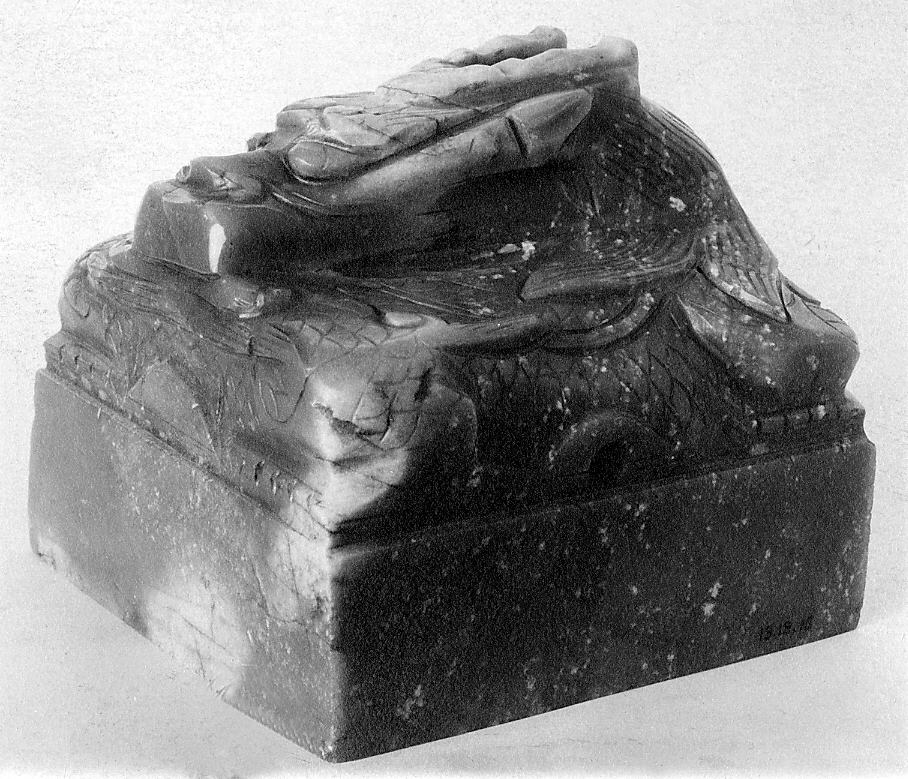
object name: seal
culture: chinese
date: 1368-1644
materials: jade